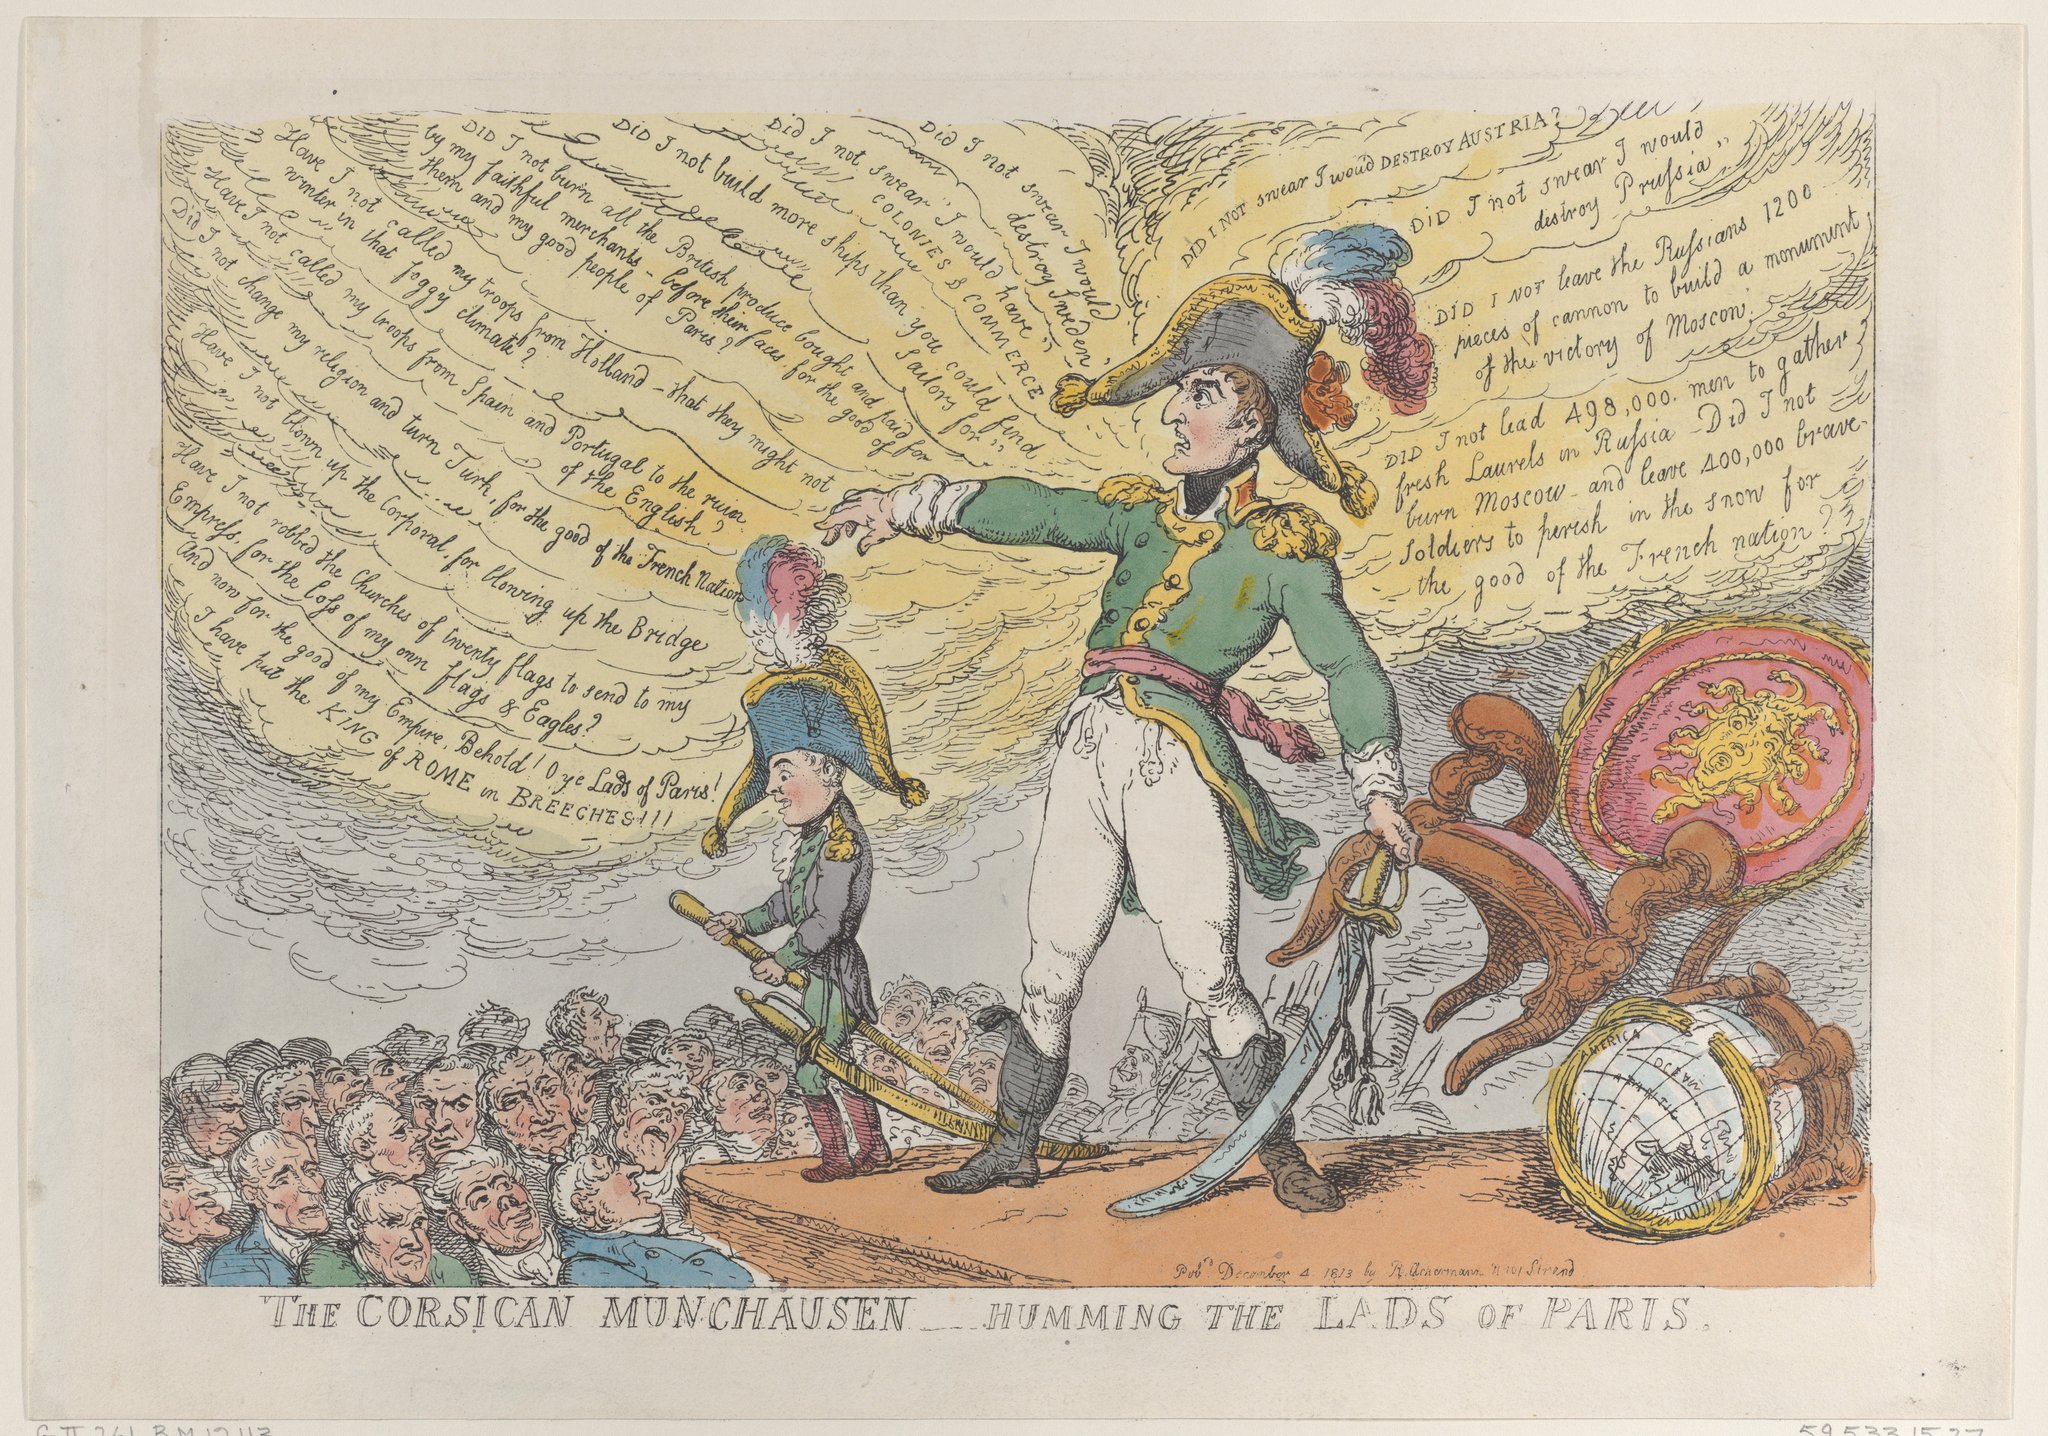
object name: print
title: The Corsican Munchausen – Humming the Lads of Paris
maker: thomas rowlandson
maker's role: artist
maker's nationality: british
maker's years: 1757-1827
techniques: etching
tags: satire,napoleon i,politics